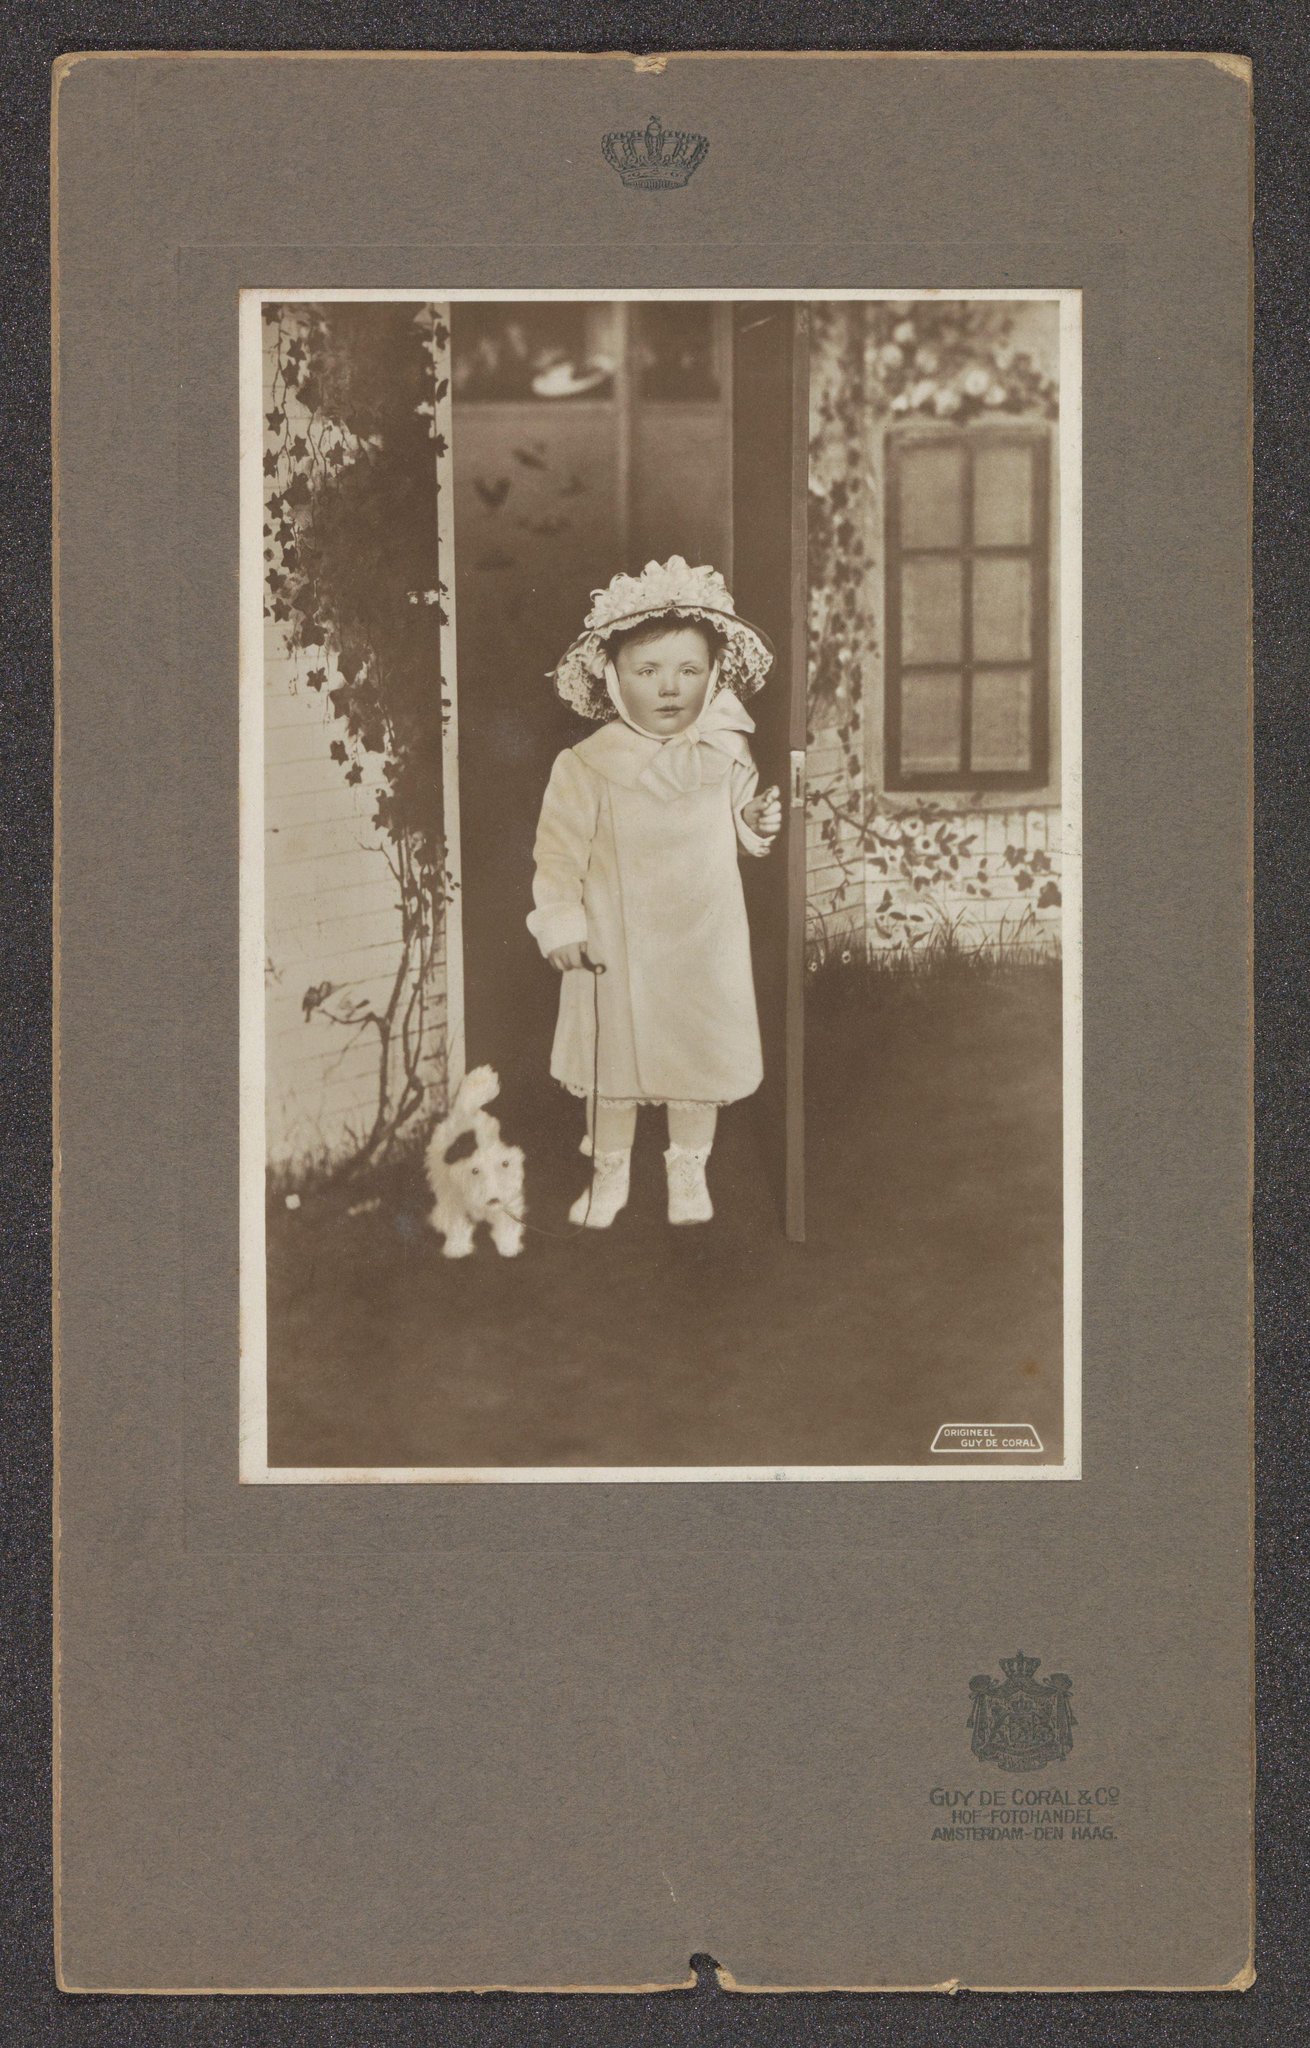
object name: photograph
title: Kinderportret van Prinses Juliana met een hond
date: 1912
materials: cardboard, paper, photographic support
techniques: gelatin silver print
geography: amsterdam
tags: juliana of the netherlands, the hague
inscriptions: stamp: ‘Guy de Coral Hof - fotohandel Amsterdam - Den Haag’